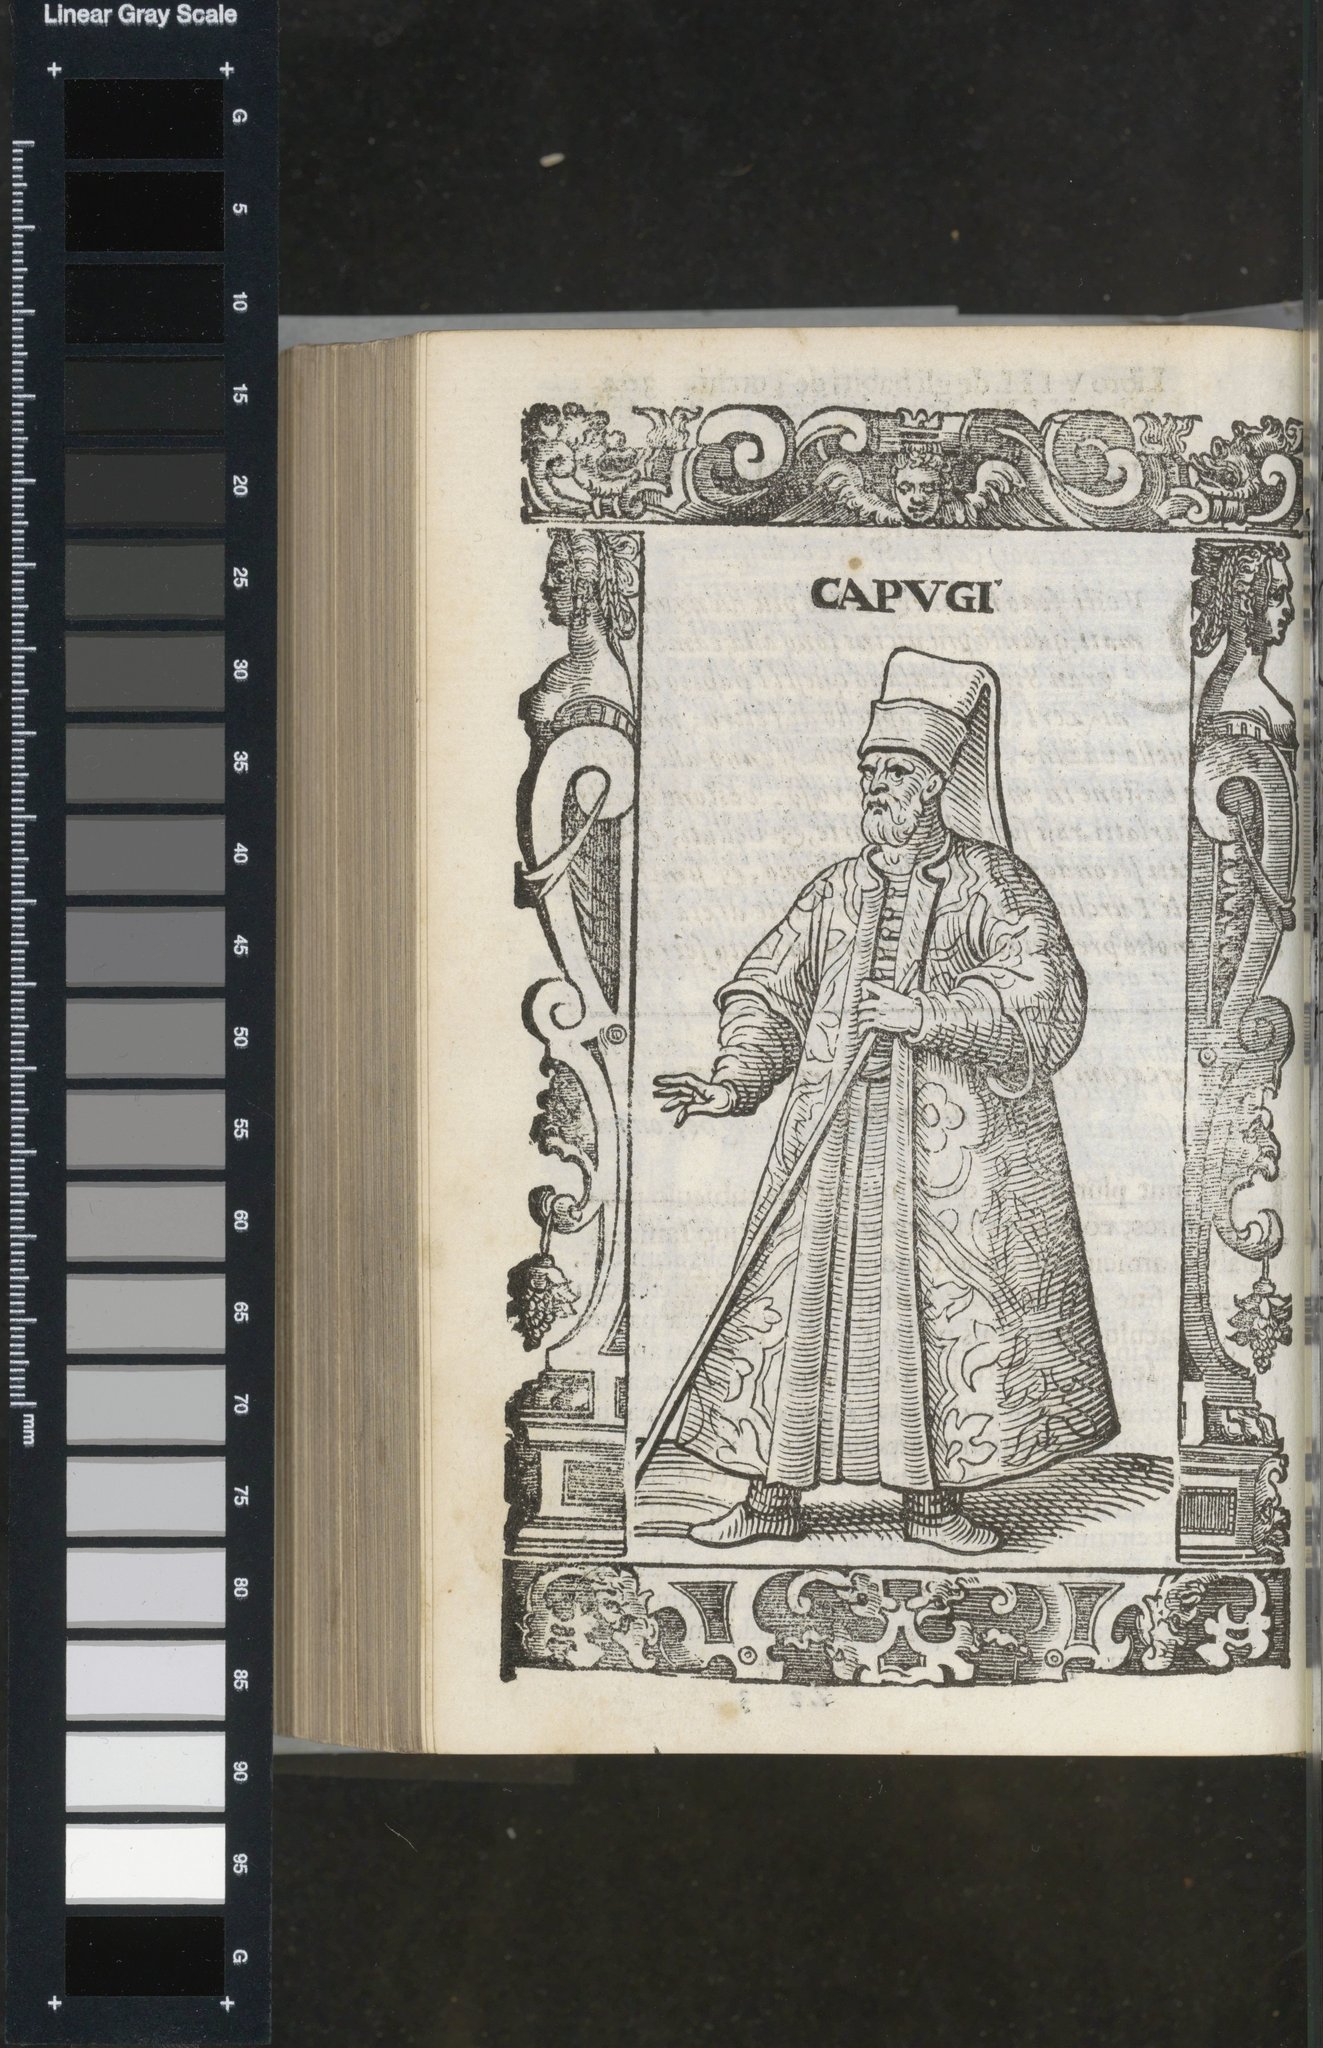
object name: costume print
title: Habiti antichi, et moderni di tutto il mondo...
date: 1598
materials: paper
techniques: woodcut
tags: fashion plates